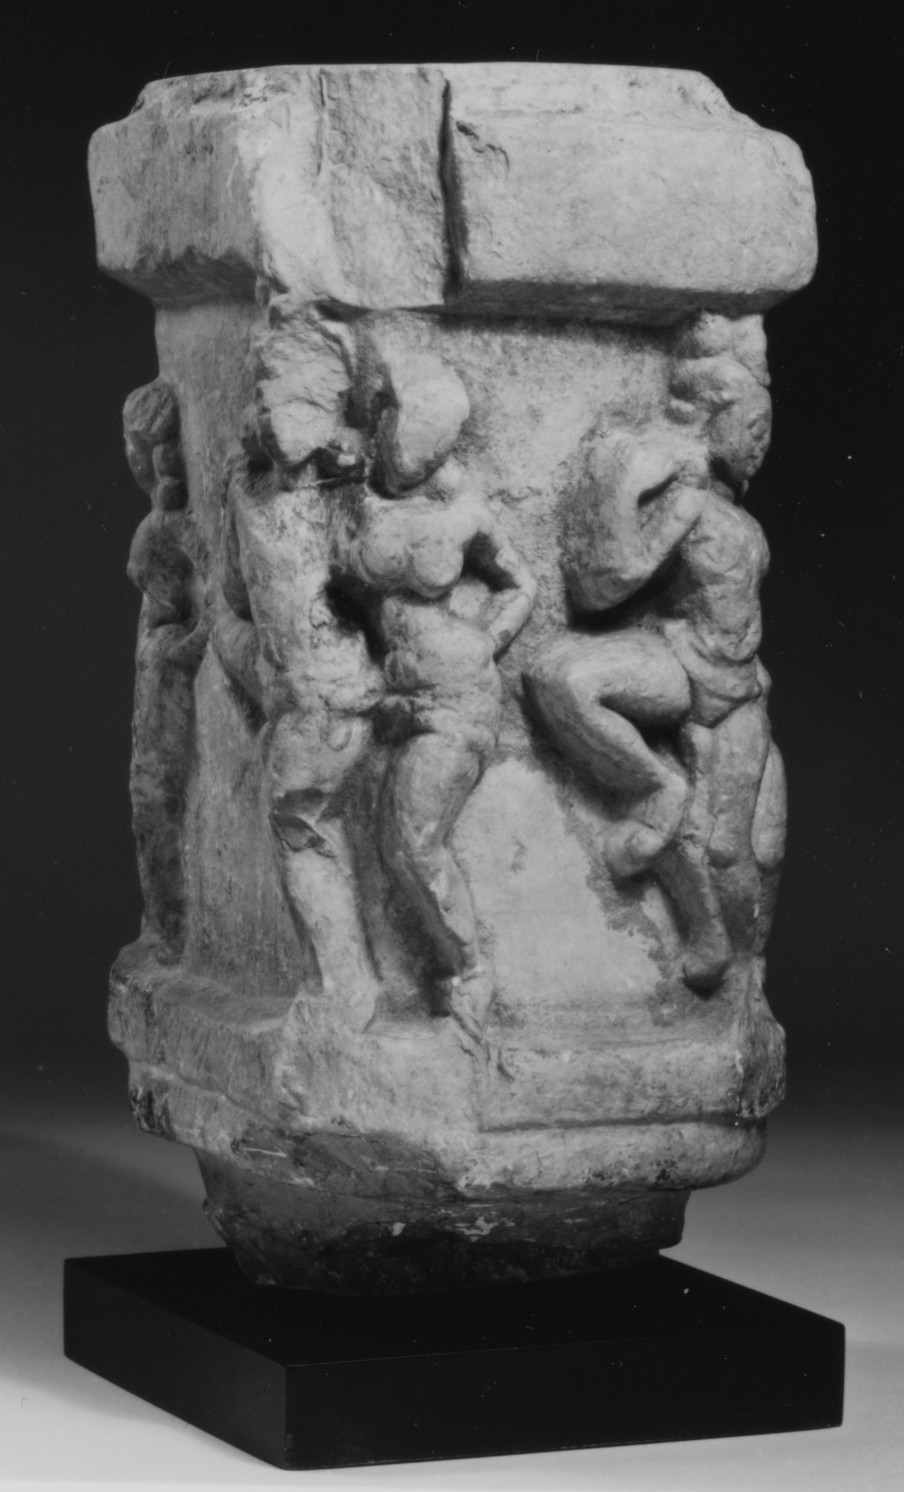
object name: pillar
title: Four-Sided Pillar with Loving Couples (Mithunas)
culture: indian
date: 201-400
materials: limestone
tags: early andhra,couples